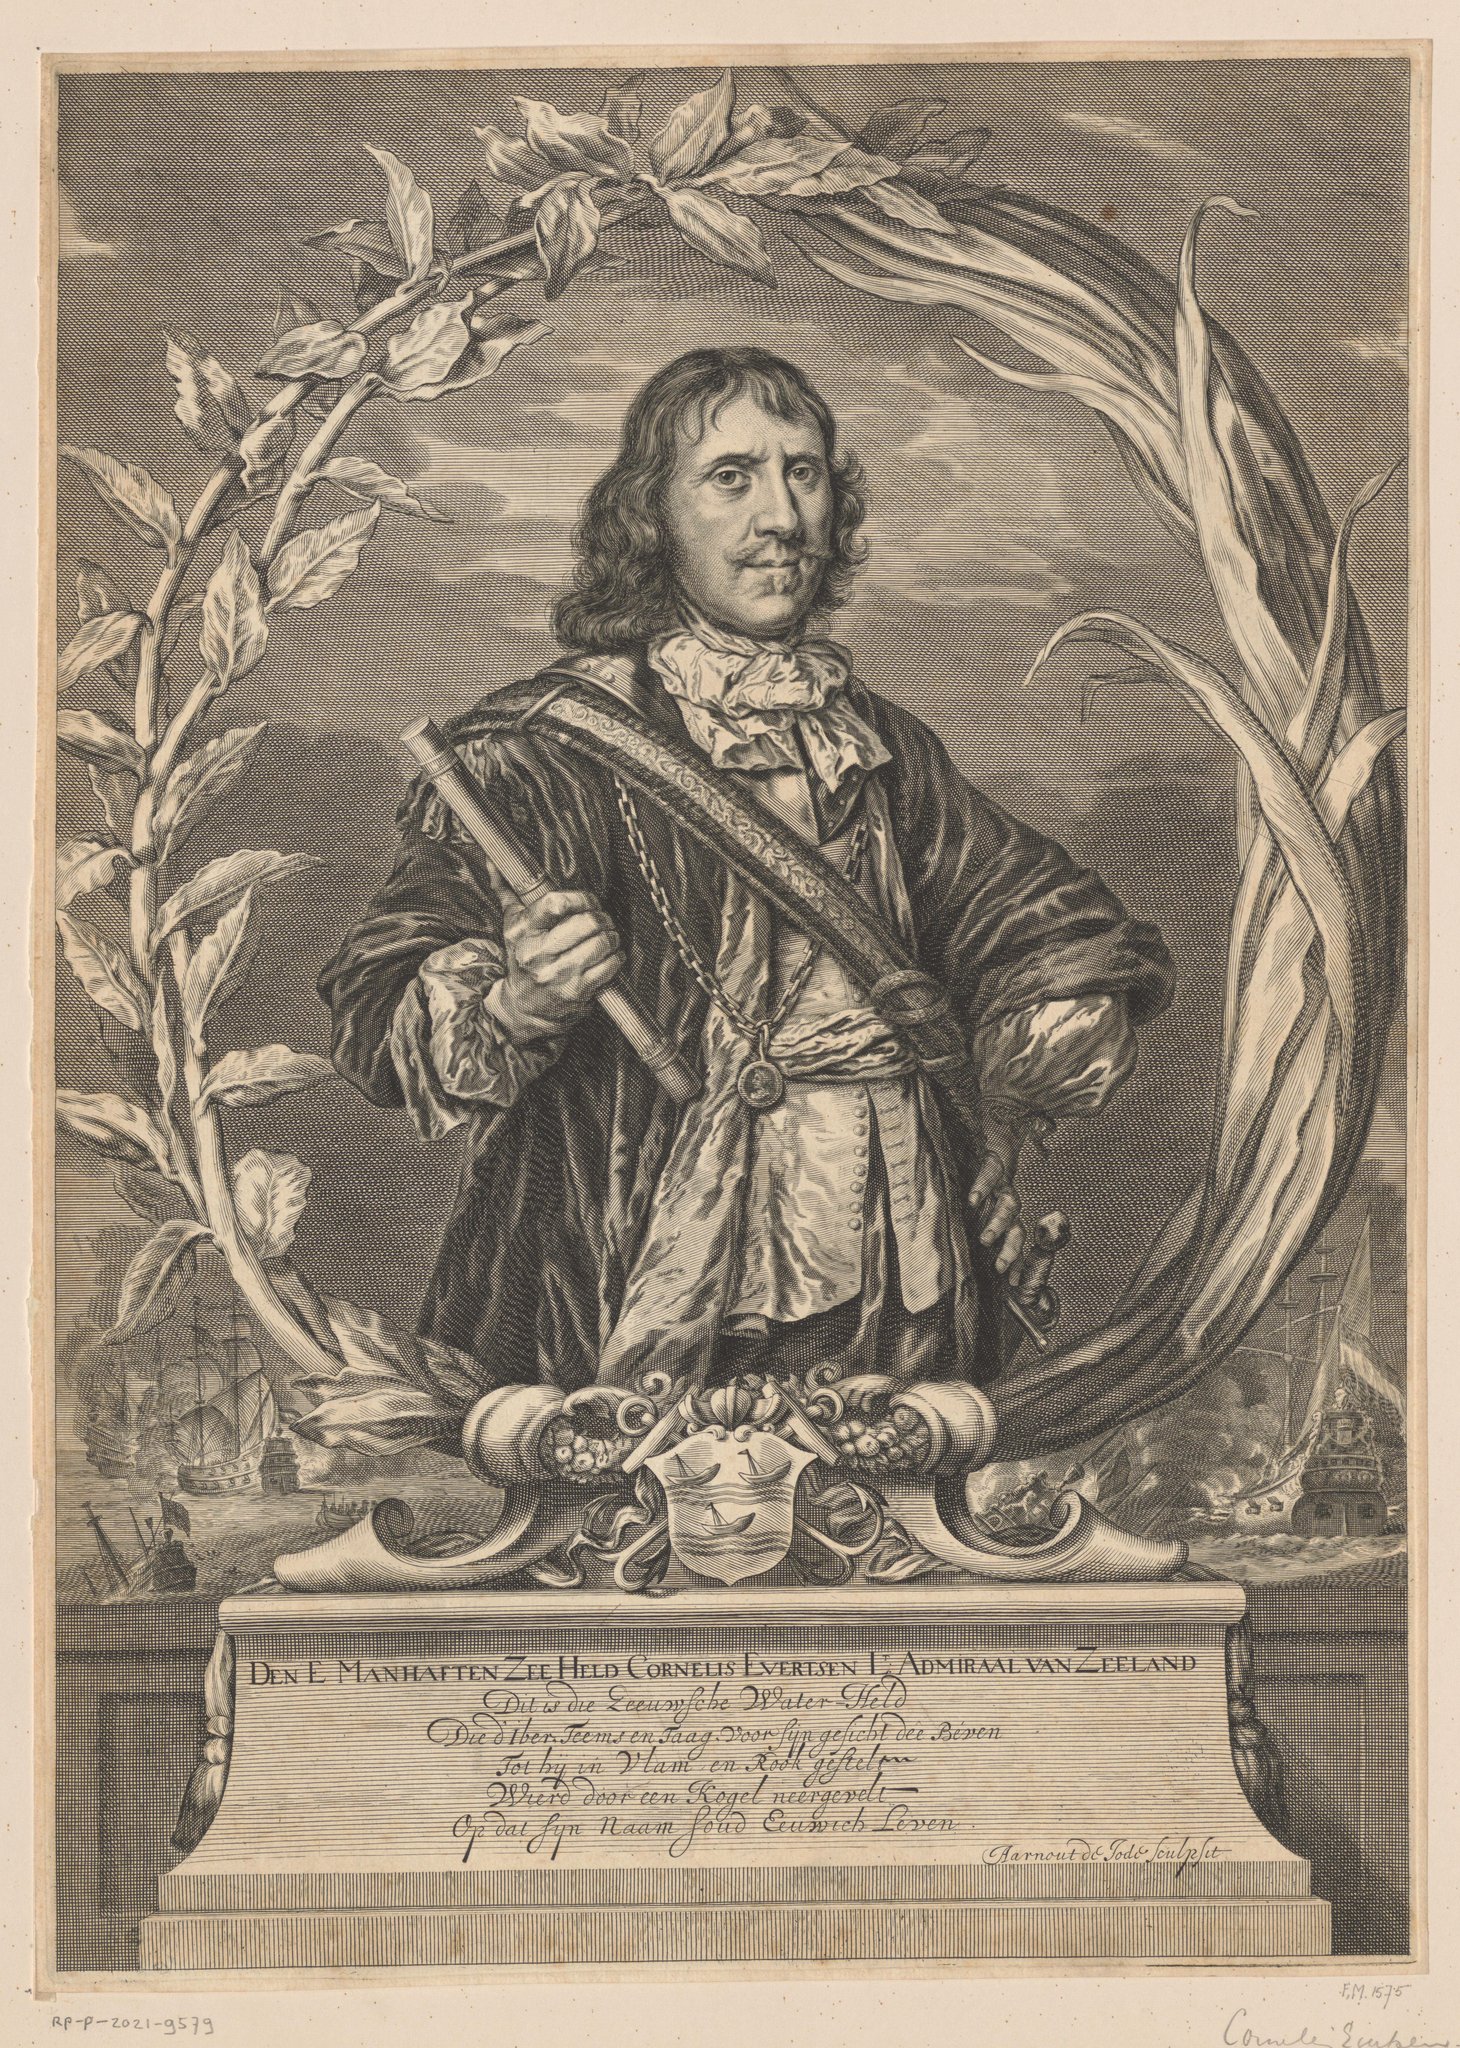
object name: print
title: Portret van Cornelis Evertsen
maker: arnold de jode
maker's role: print maker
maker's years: 1638-1669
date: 1666-1669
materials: paper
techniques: engraving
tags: battle (+ naval force), historical persons, commander-in-chief, admiral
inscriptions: inscription: ‘Coll:Franken’, number: ‘No. 34’, collector's mark: Lugt 2228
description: Op de achtergrond een zeegevecht met zinkende schepen, waarschijnlijk de Vierdaagse Zeeslag waarbij Cornelis Evertsen overleed. Met vijfregelig lofdicht in het Nederlands.